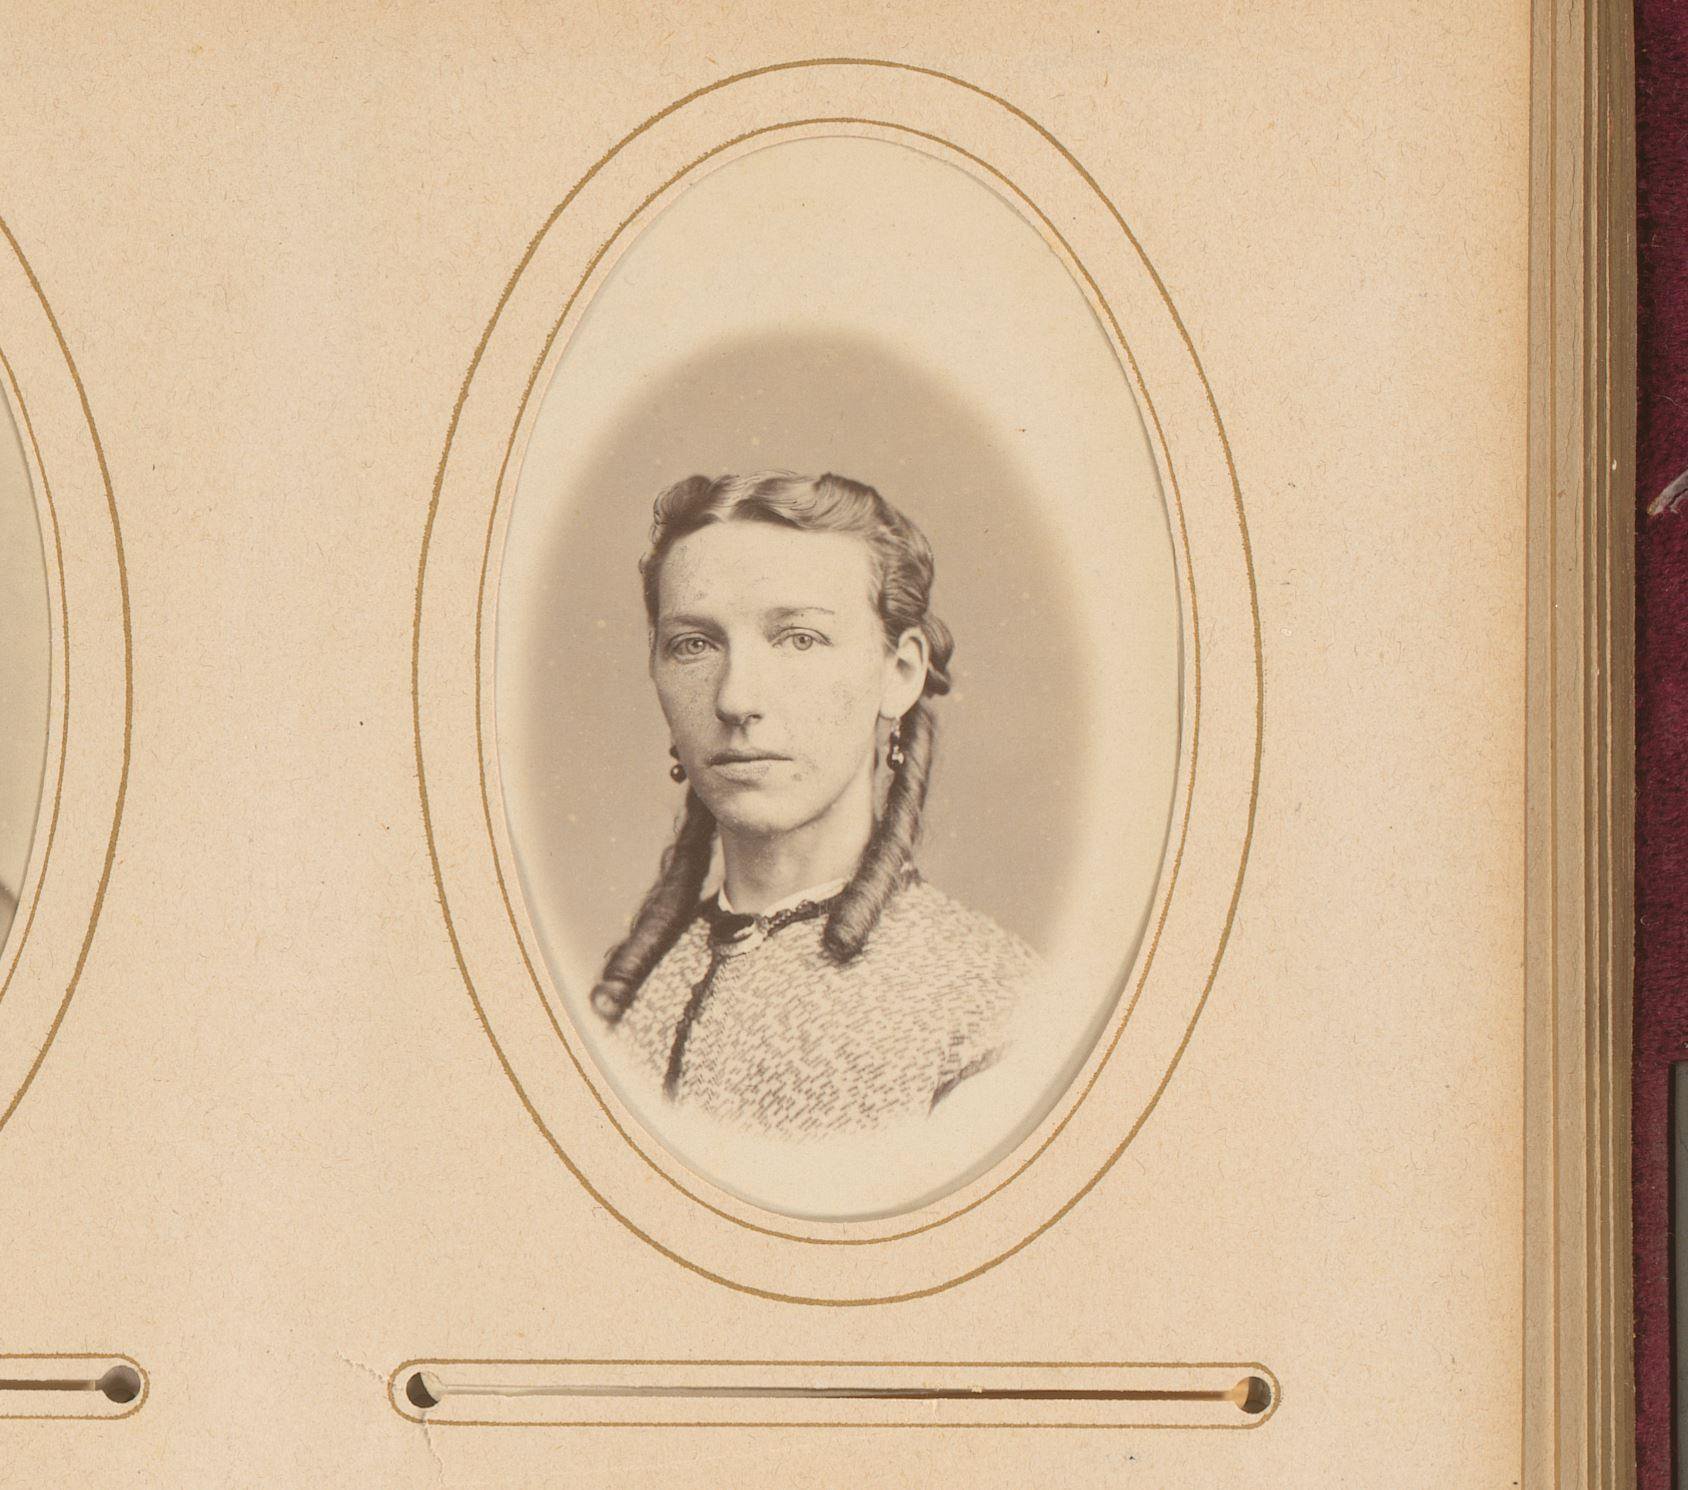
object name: album leaf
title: Portret van een vrouw met pijpenkrullen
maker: a. siegmund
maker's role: fotograaf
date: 1860-1880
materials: cardboard, photographic support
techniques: albumen print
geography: hamburg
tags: historical persons - bb - woman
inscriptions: inscription: ‘Photographisches Atelier/ von A. Siegmund/ 16, Bazar, 16/ Hamburg’